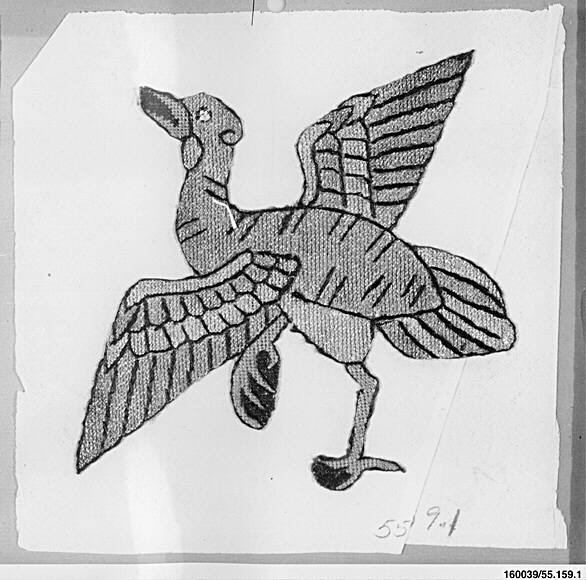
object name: appliqué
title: Applique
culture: chinese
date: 1867-1933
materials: metal thread, silk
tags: birds